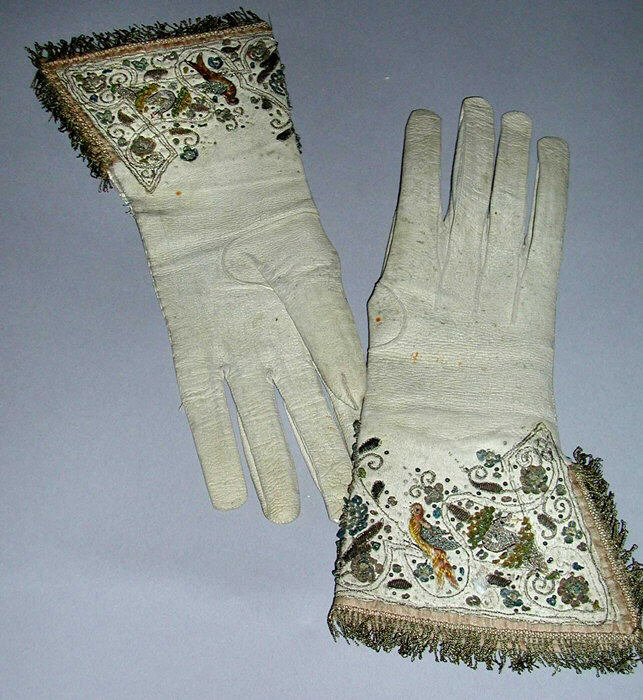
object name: glove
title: Gloves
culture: british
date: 1601-1700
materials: leather, metal thread, silk